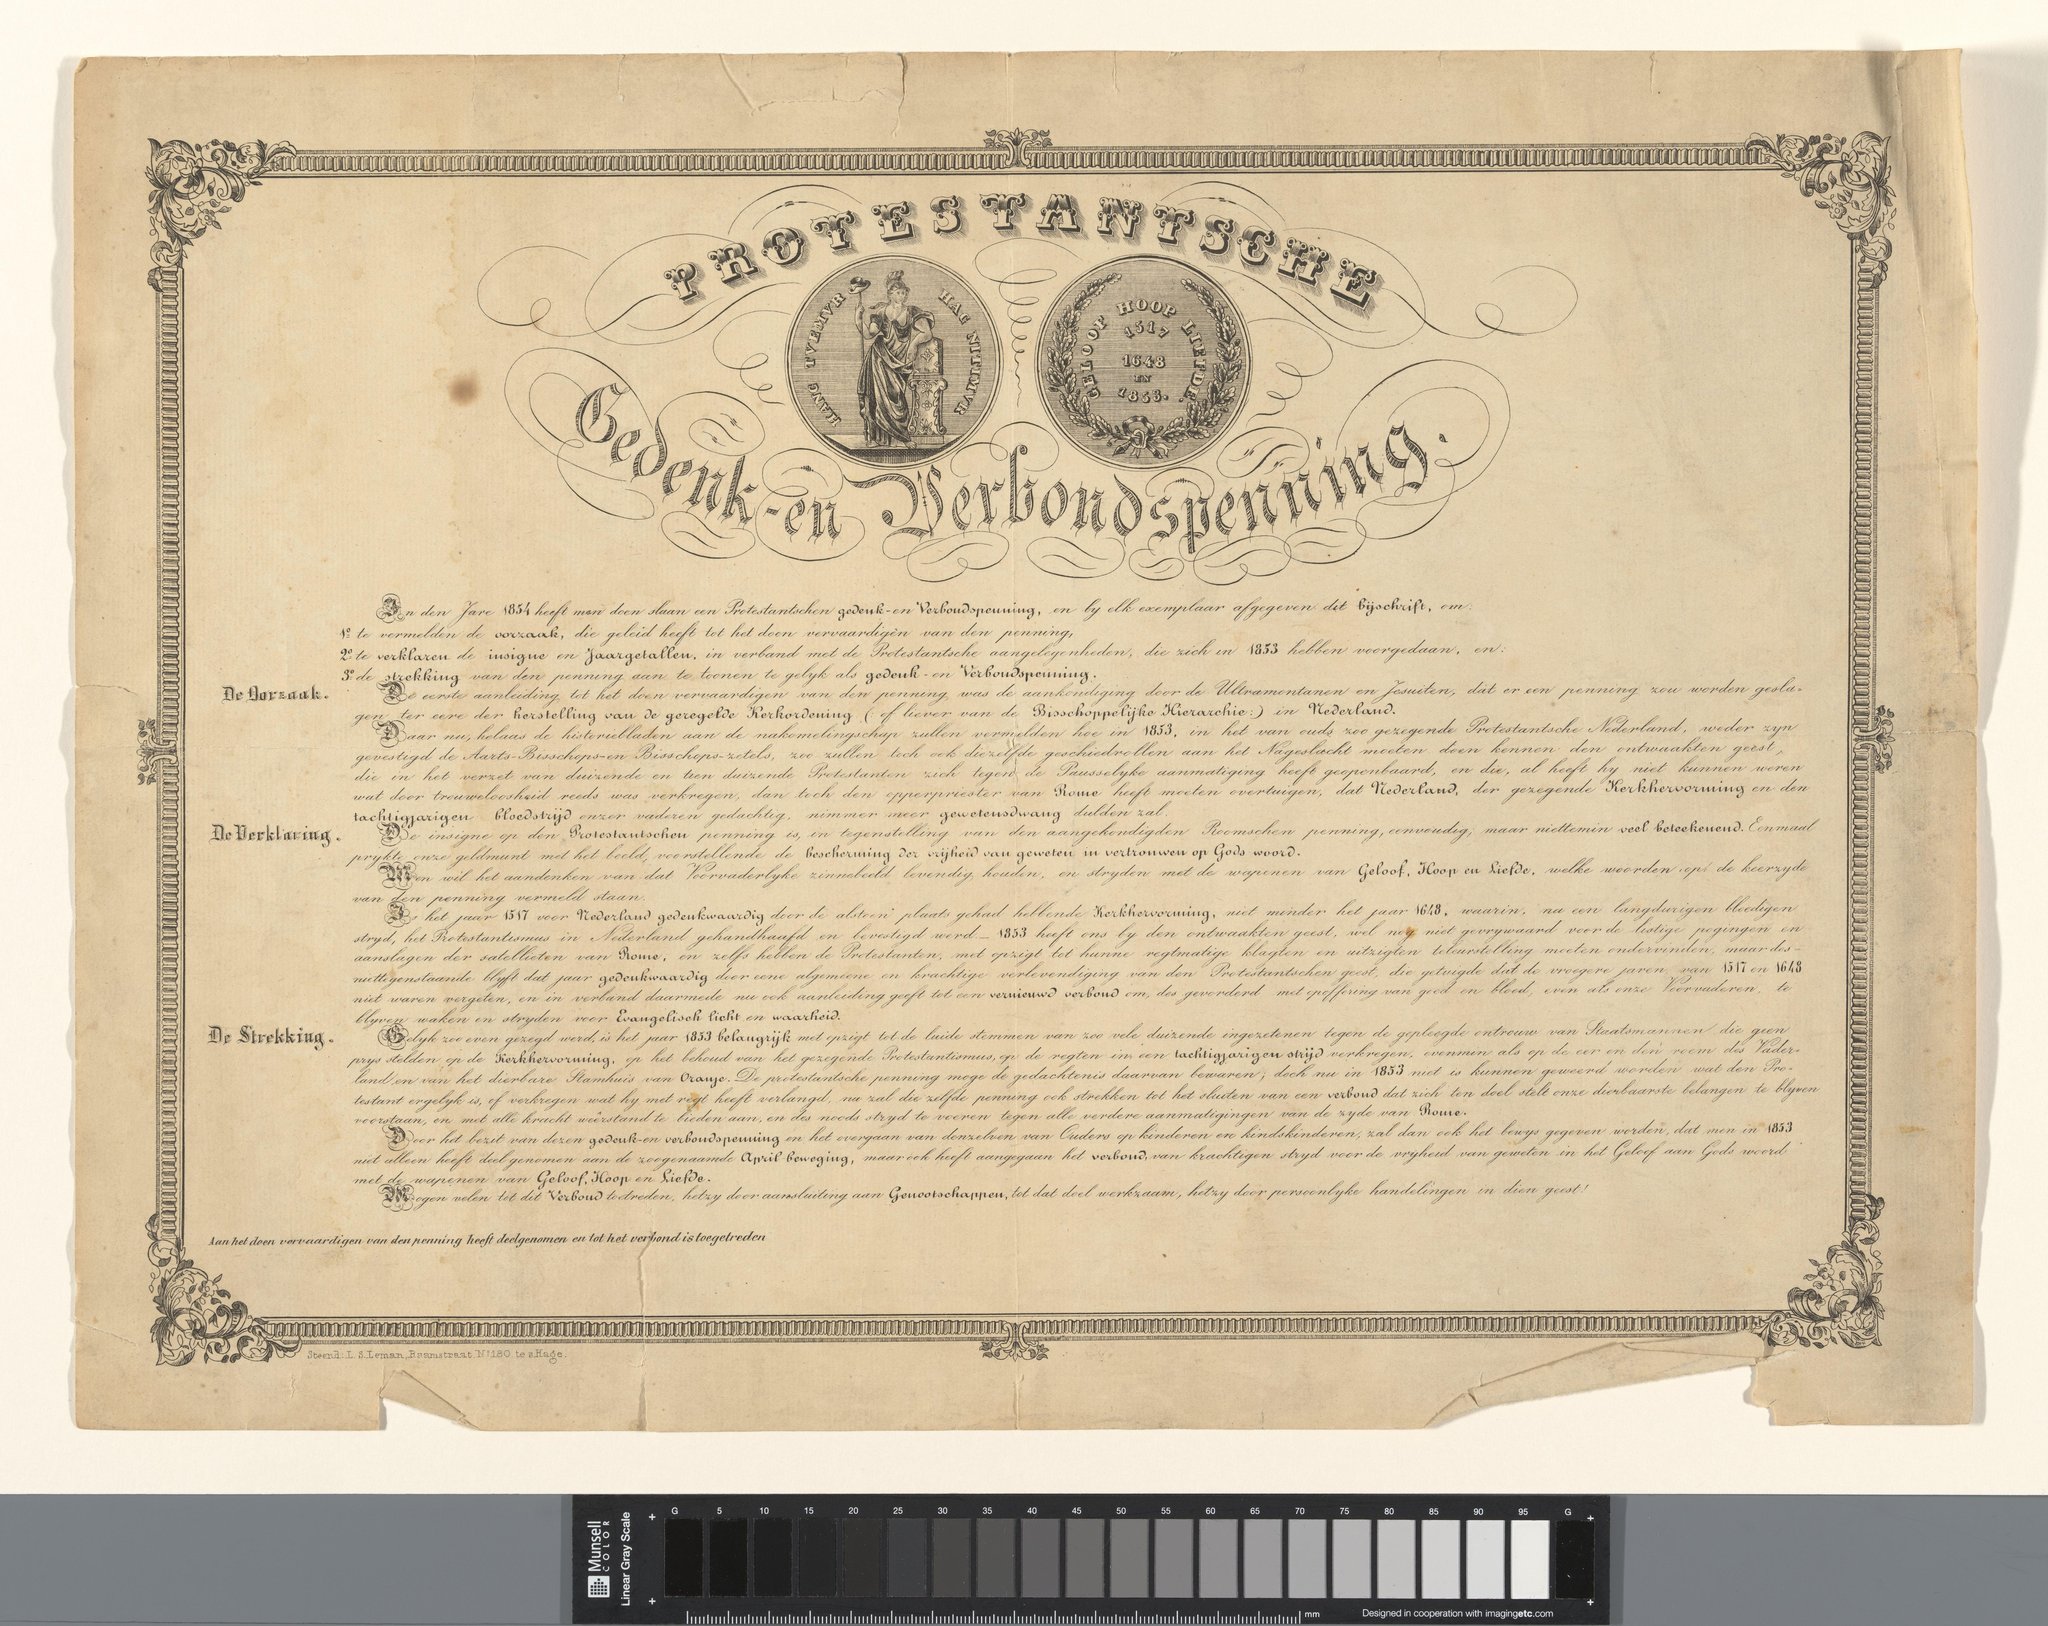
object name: document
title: Document over de protestantse gedenk- en verbondspenning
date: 1854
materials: paper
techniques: printing, writing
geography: the hague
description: Eenzijdig gelithografeerd document over de protestantse gedenk- en verbondspenning (aprilbeweging): oorspronkelijk een handgeschreven tekst in kader met bladmotief in de hoeken. Midden boven: afbeelding van penning (voorzijde en keerzijde). Naam van nieuw verbondslid is niet ingevuld. In dit document staat de reden, verklaring en strekking van de penning die met betrekking tot de aprilbeweging werd geslagen.